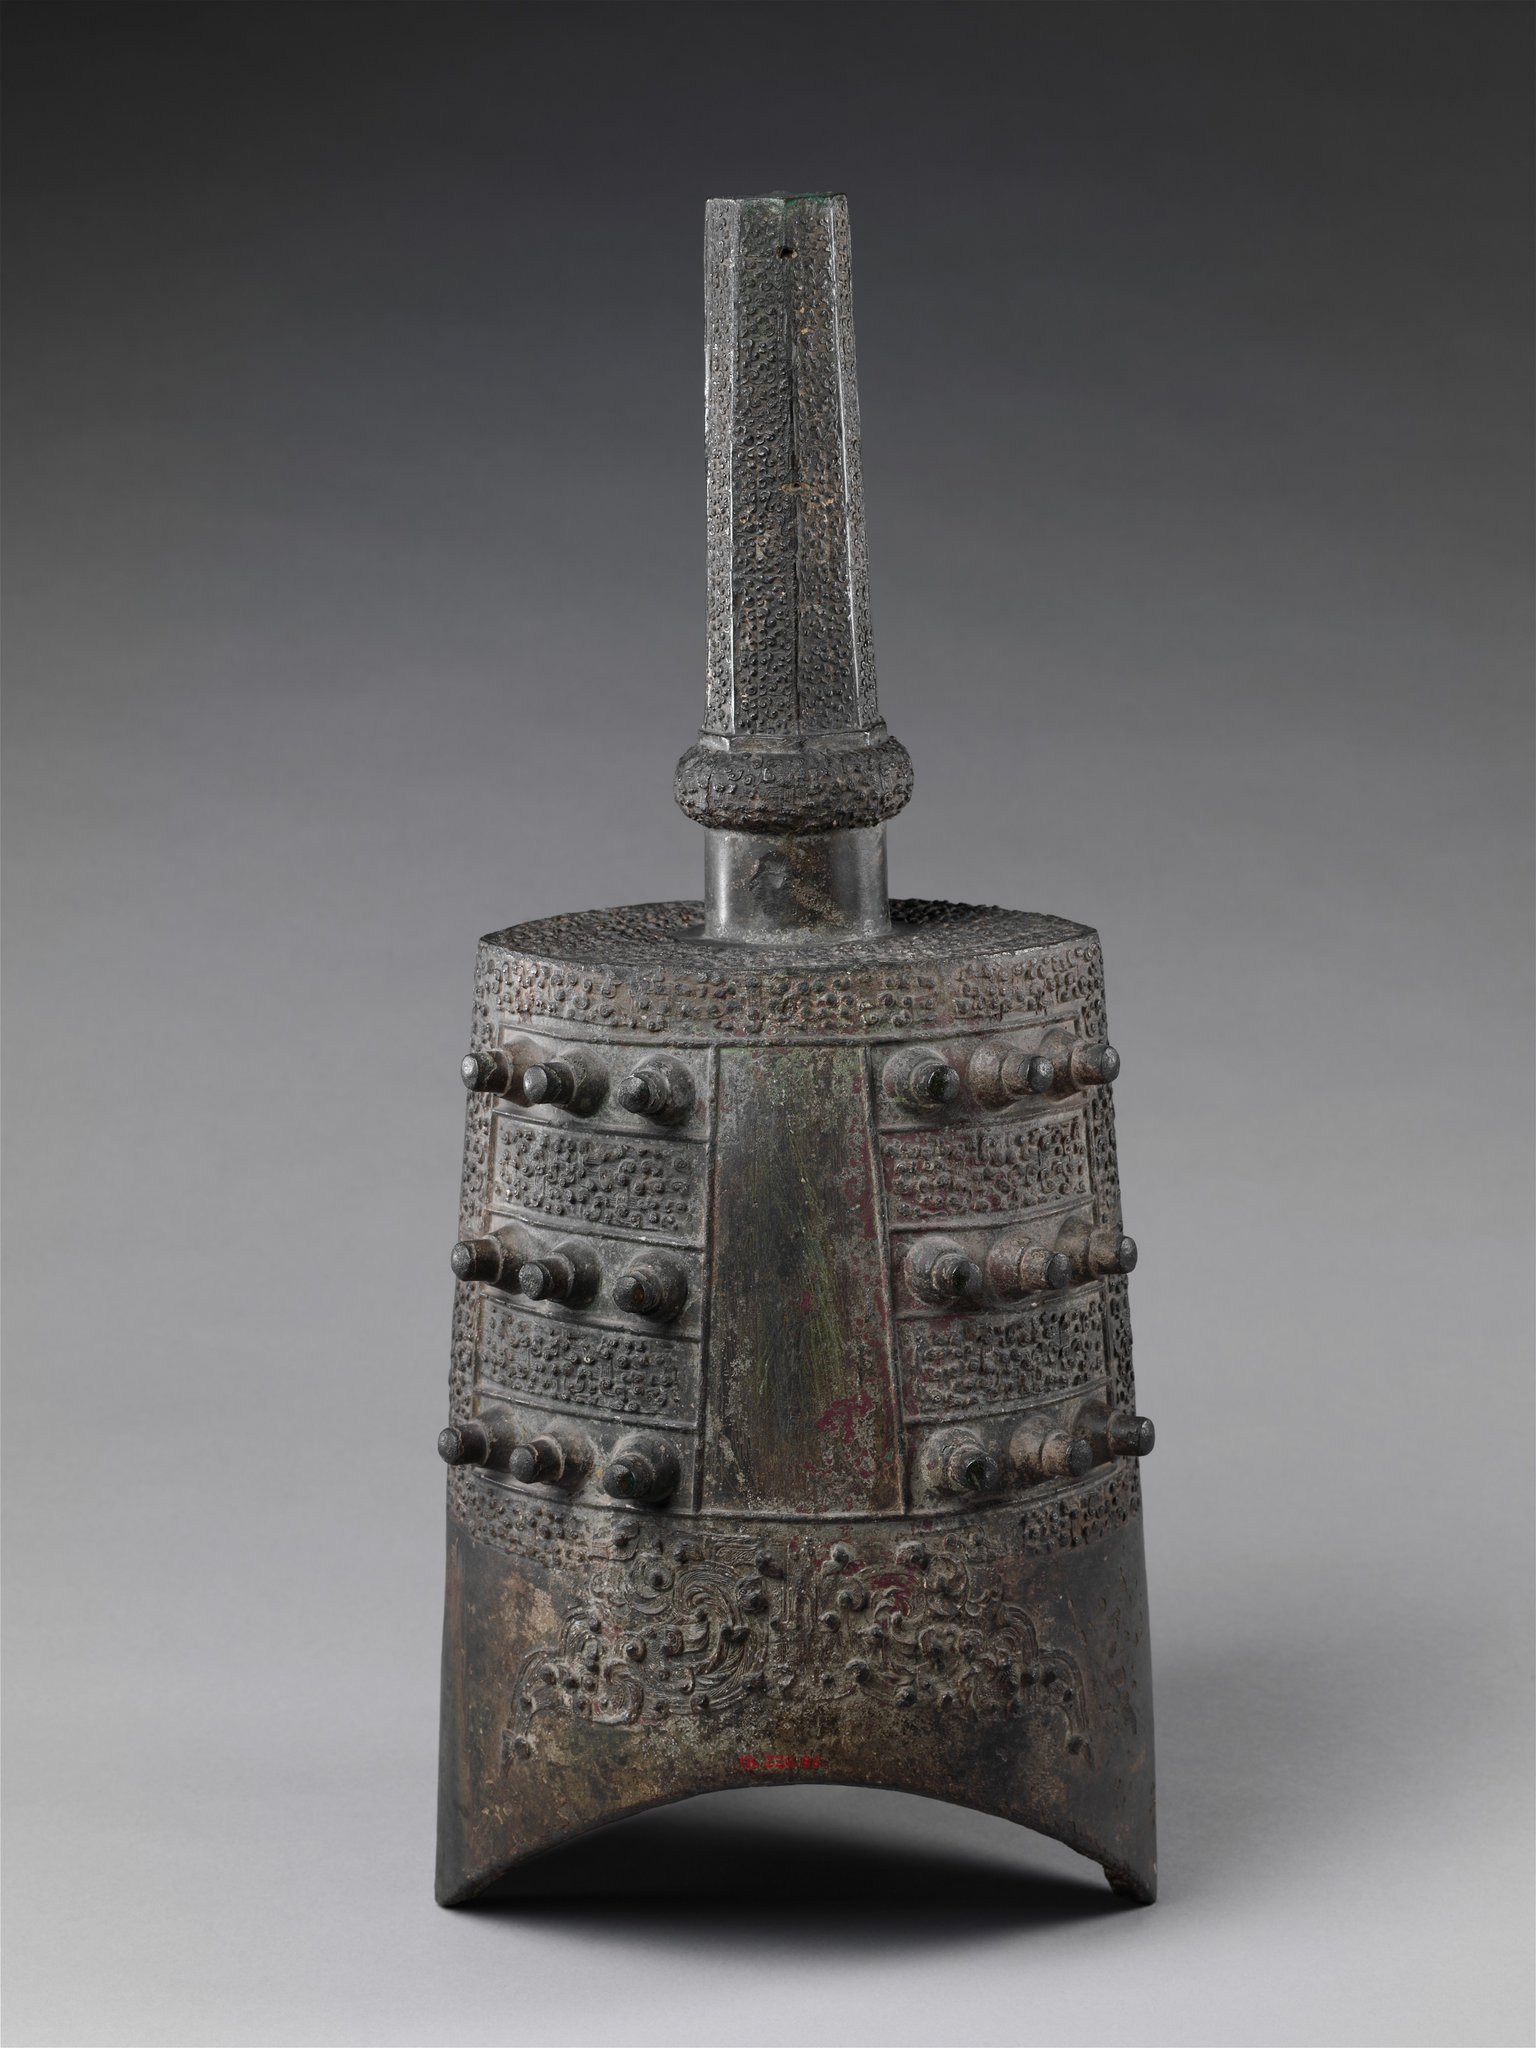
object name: bell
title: Bell (Yongzhong)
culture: chinese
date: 500-201 BCE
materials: bronze